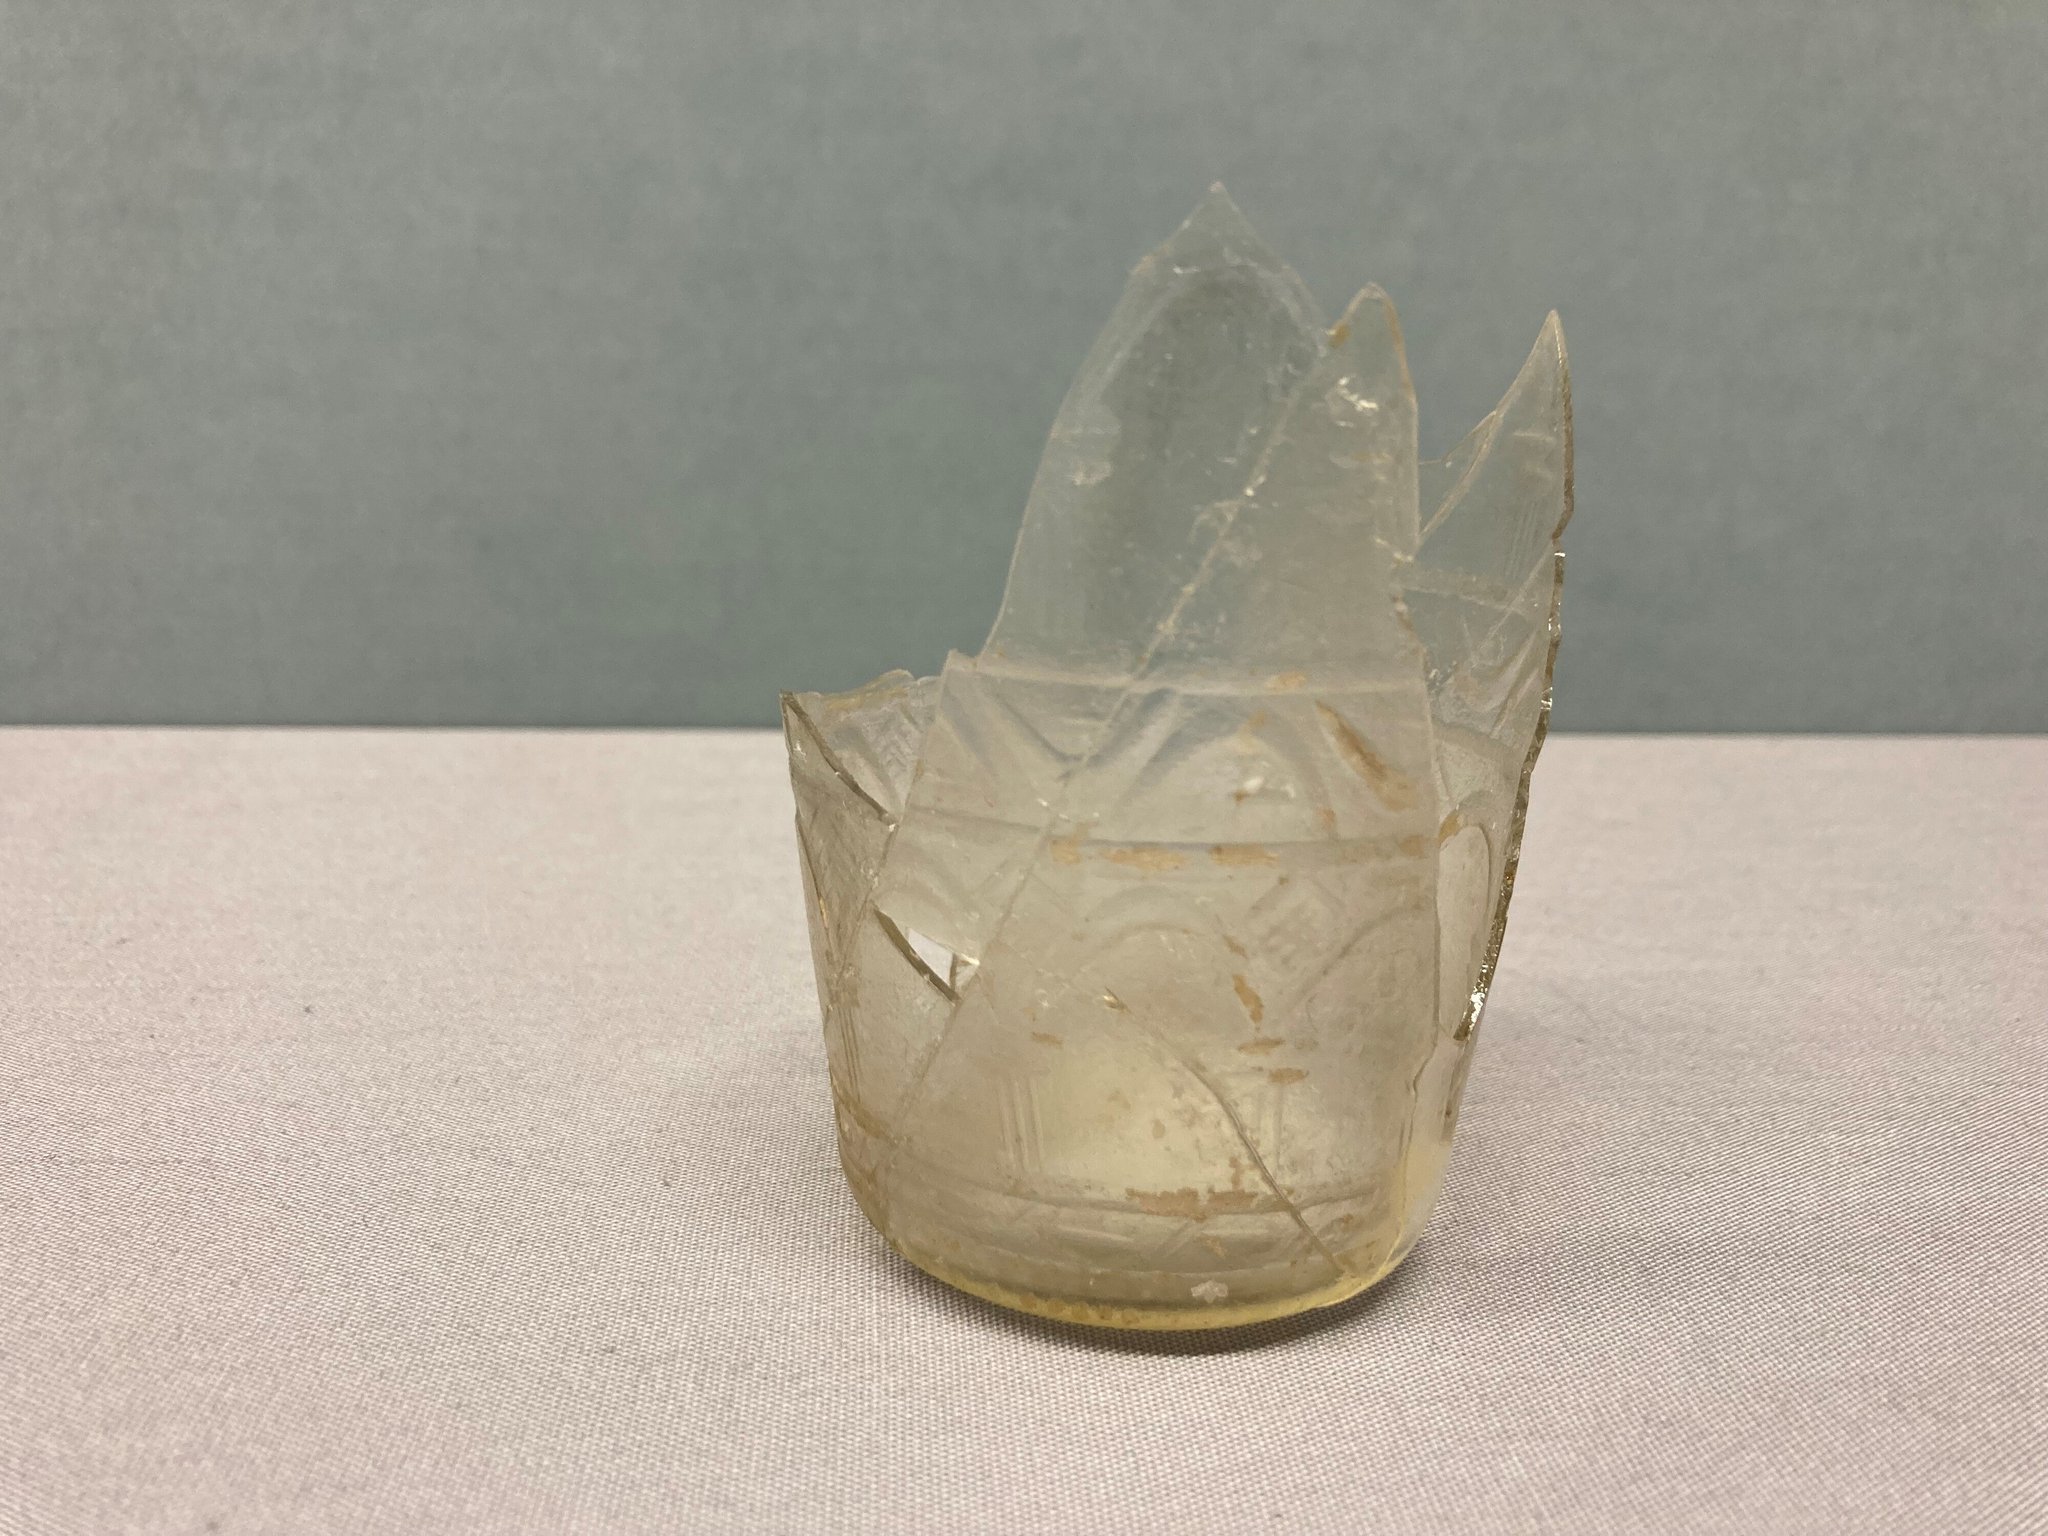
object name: fragment of a beaker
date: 901-1000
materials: glass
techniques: cutting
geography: iran